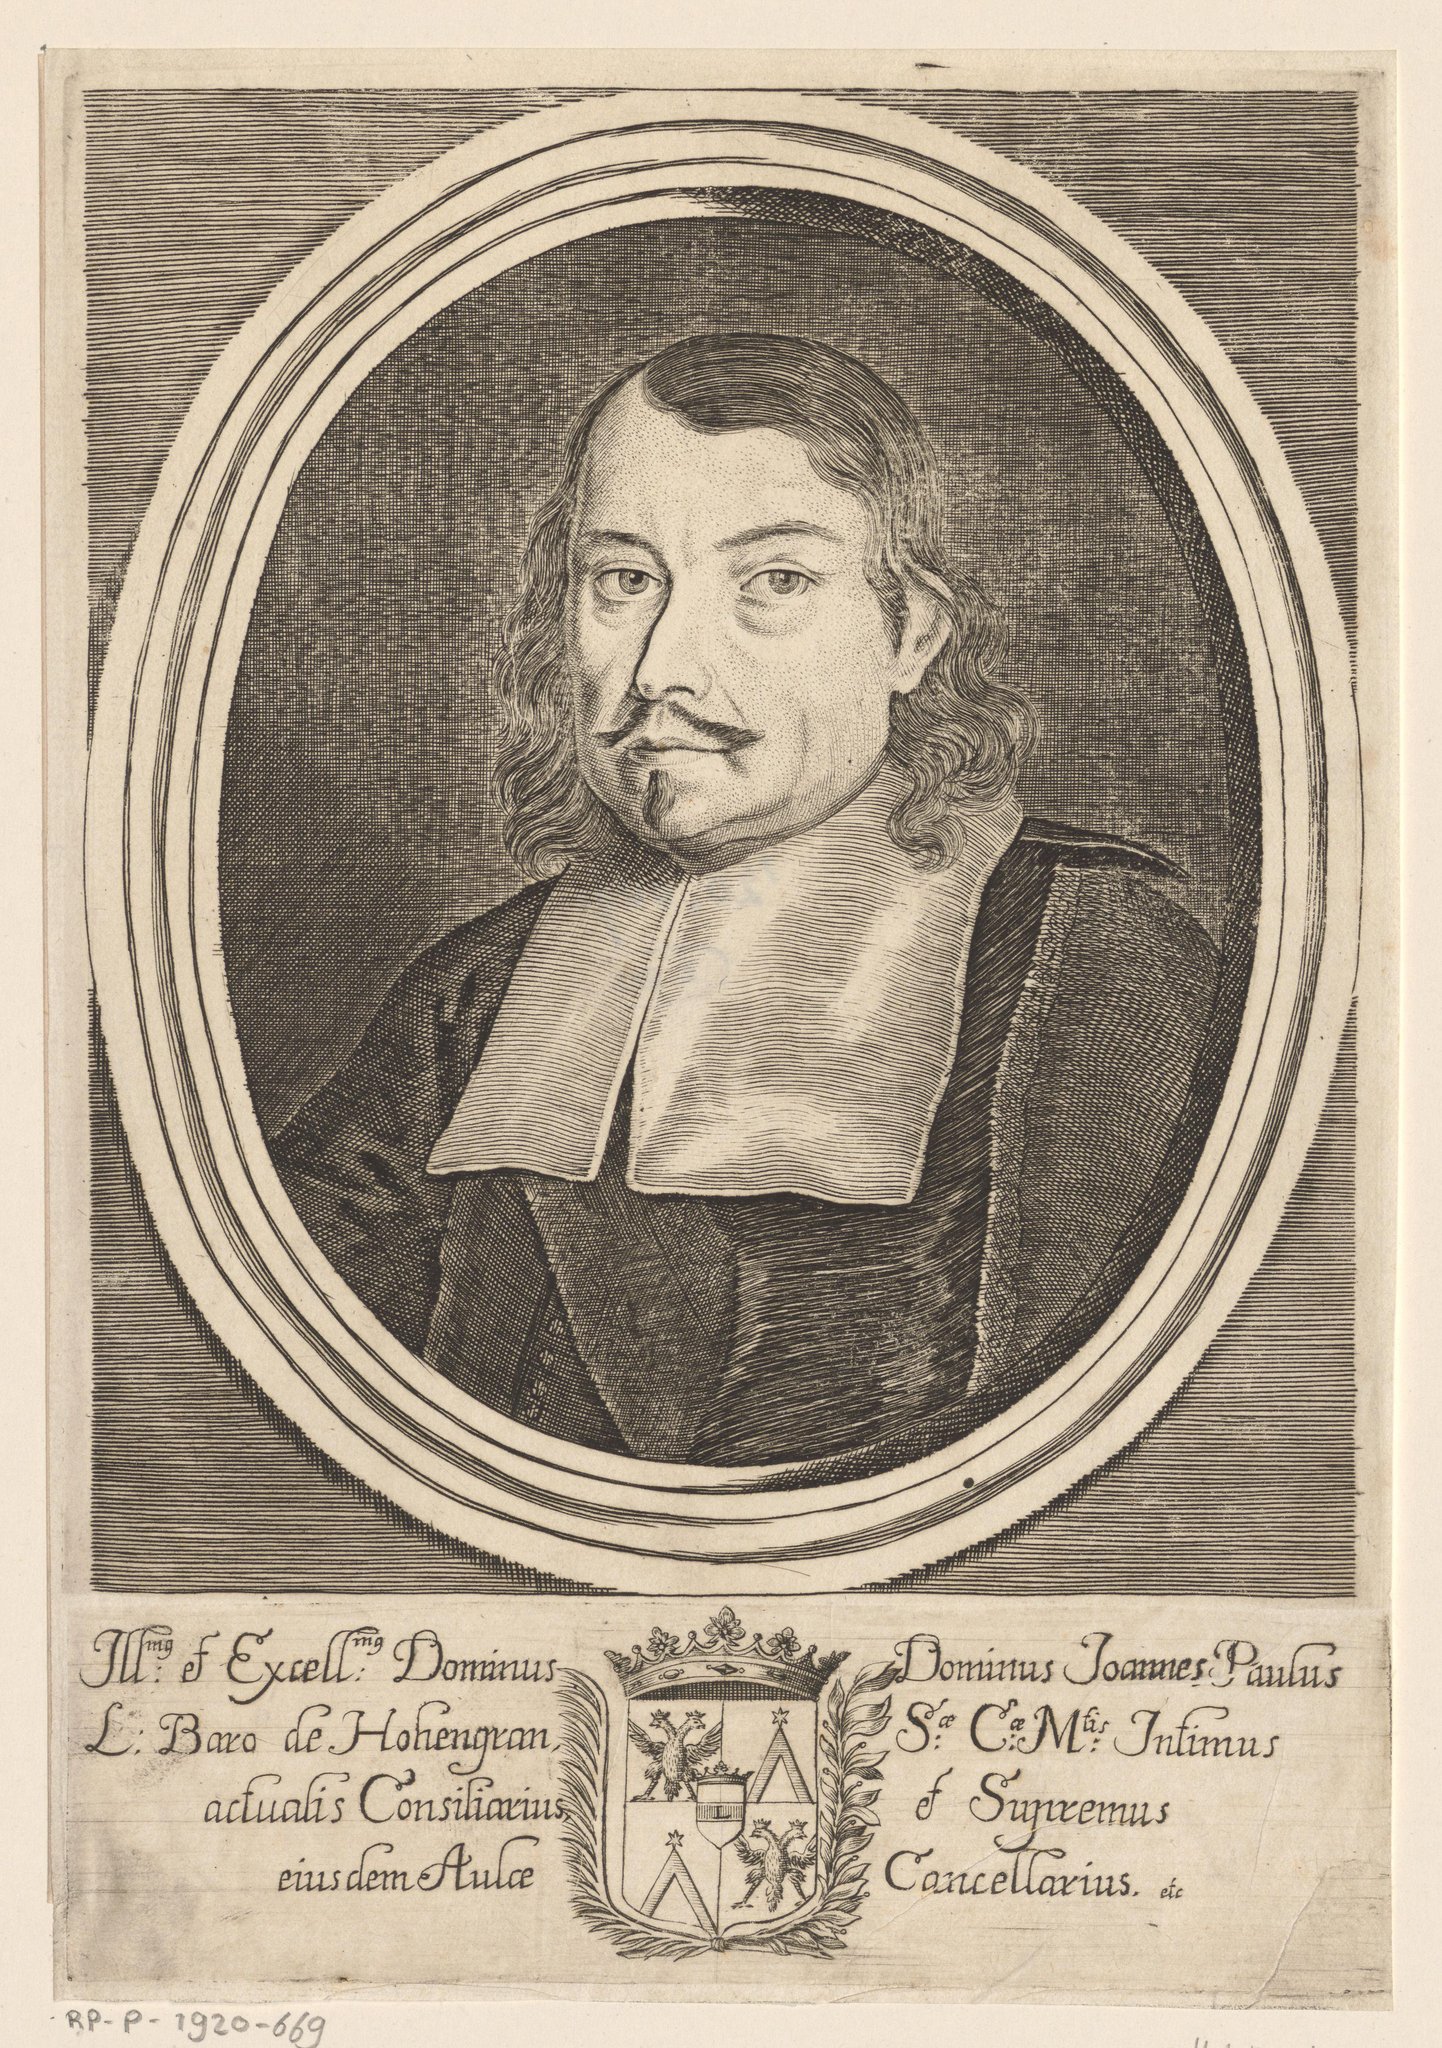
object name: print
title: Portret van Johann Paul Hocher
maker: Anonymous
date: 1667-1699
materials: paper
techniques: engraving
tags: vienna, politician, historical persons, armorial bearing, heraldry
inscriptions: collector's mark: Lugt 2228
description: Prent mogelijk uit: Weingarten, Johann Jacob von. Fürstenspiegel. Praag: Johann Arnold, 1673.